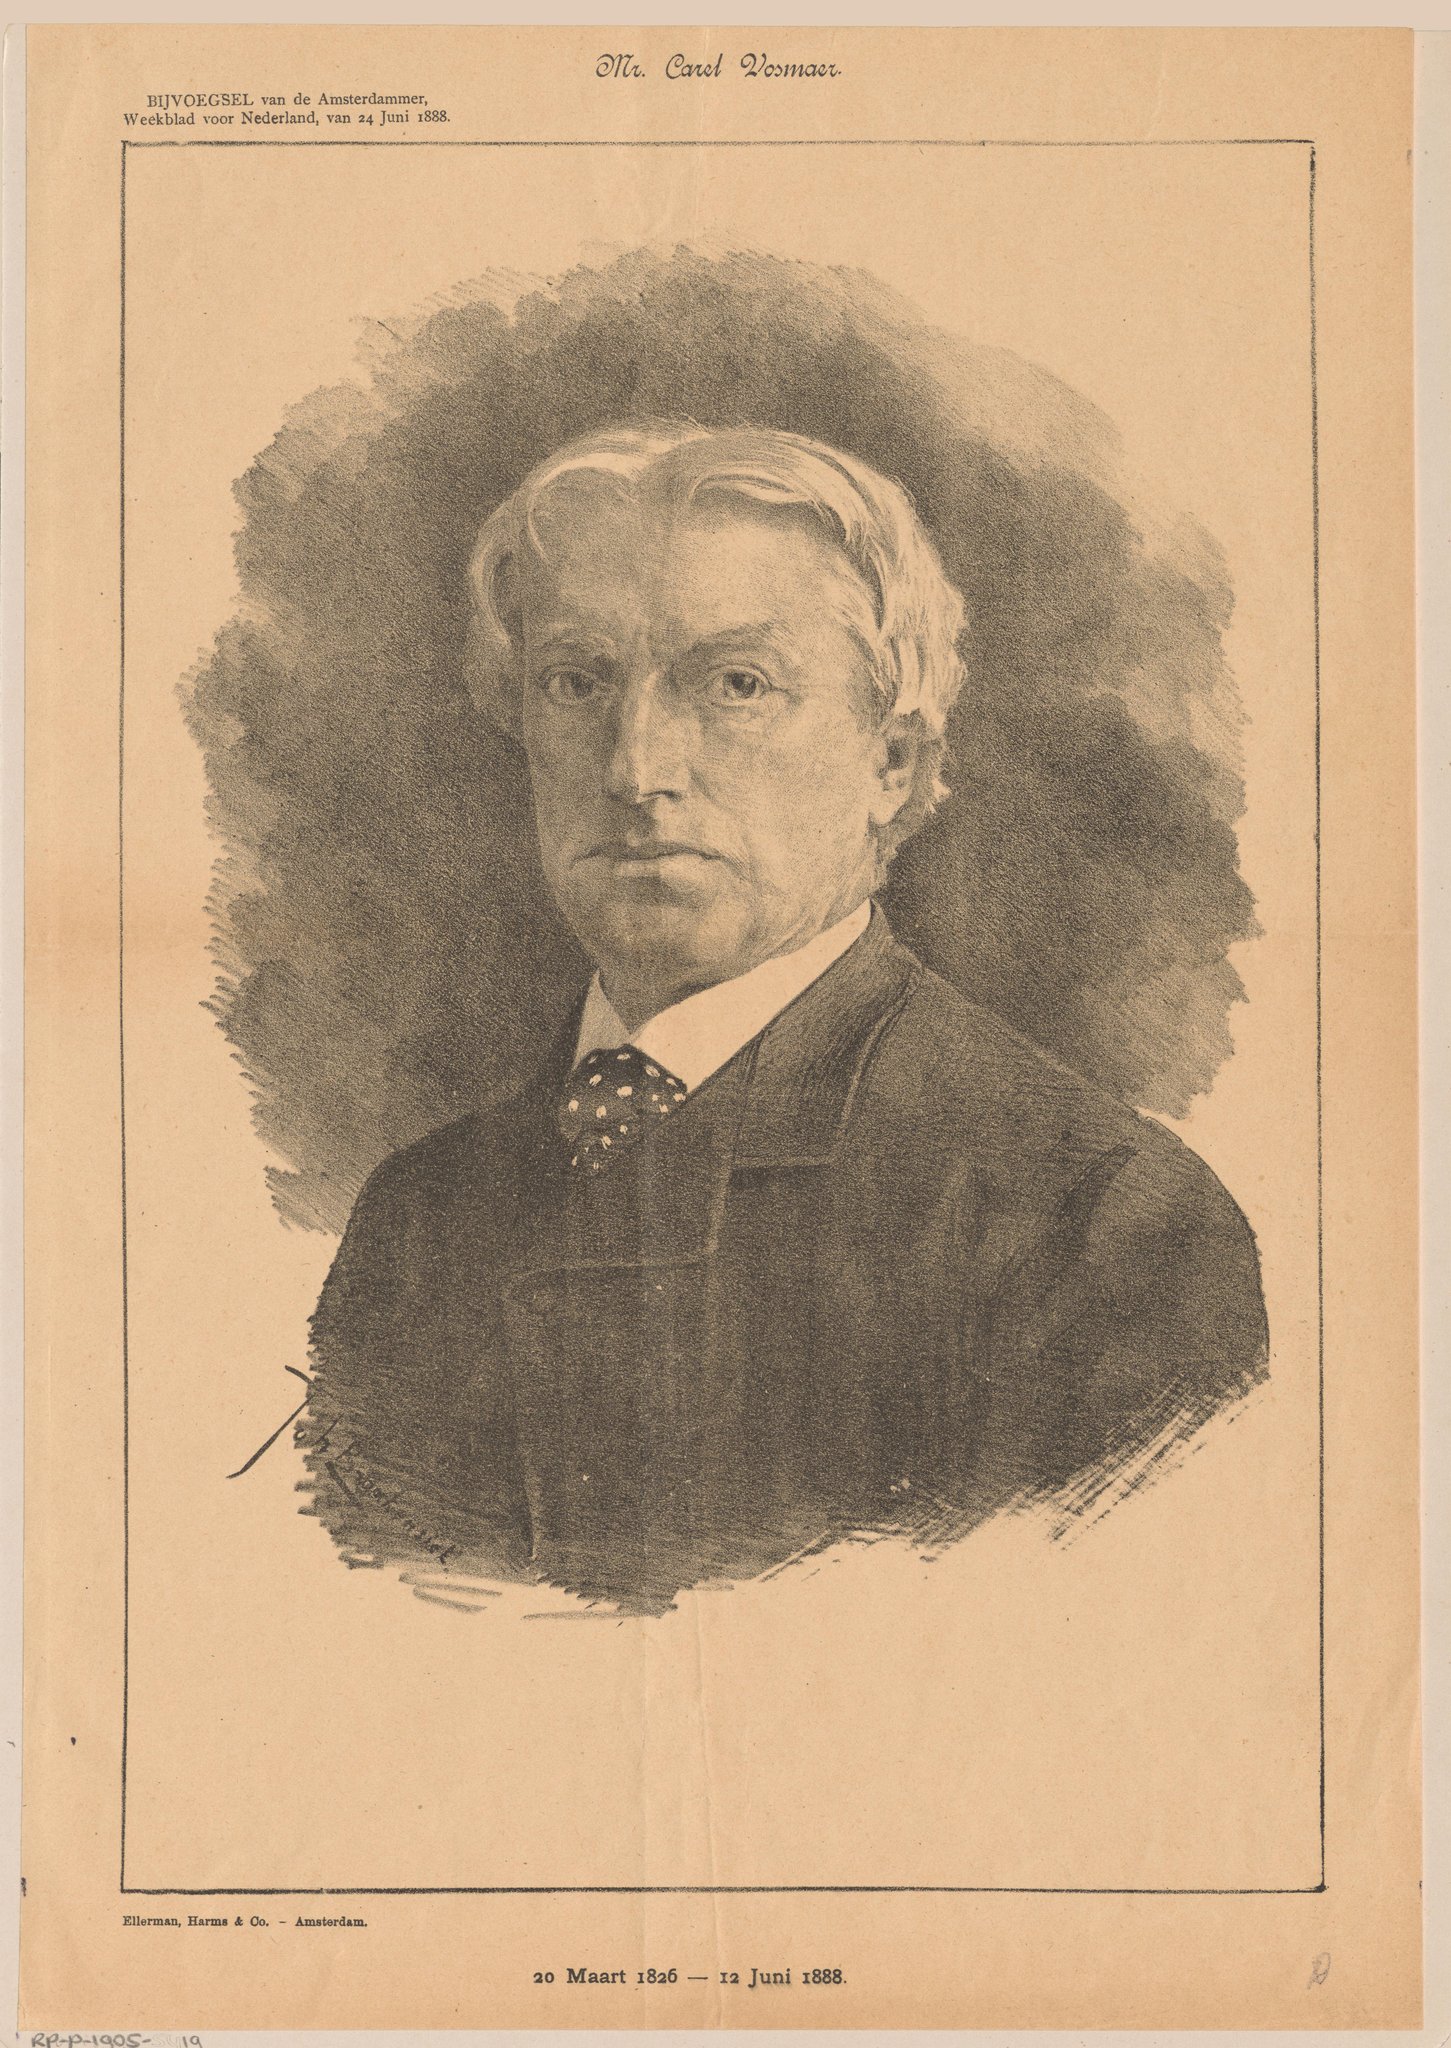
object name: print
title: Portret van Carel Vosmaer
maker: johan braakensiek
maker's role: draughtsman, print maker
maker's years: 1858-1940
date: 1888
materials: paper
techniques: lithograph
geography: amsterdam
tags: the hague, print maker, draughtsman, carel vosmaer, historical persons, portrait of a writer, portrait, self-portrait of graphic artist, portrait, self-portrait of draughtsman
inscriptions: collector's mark: Lugt 2228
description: Dit portret werd uitgegeven als bijvoegsel bij De Amsterdammer, Weekblad voor Nederland op 24 juni 1888.